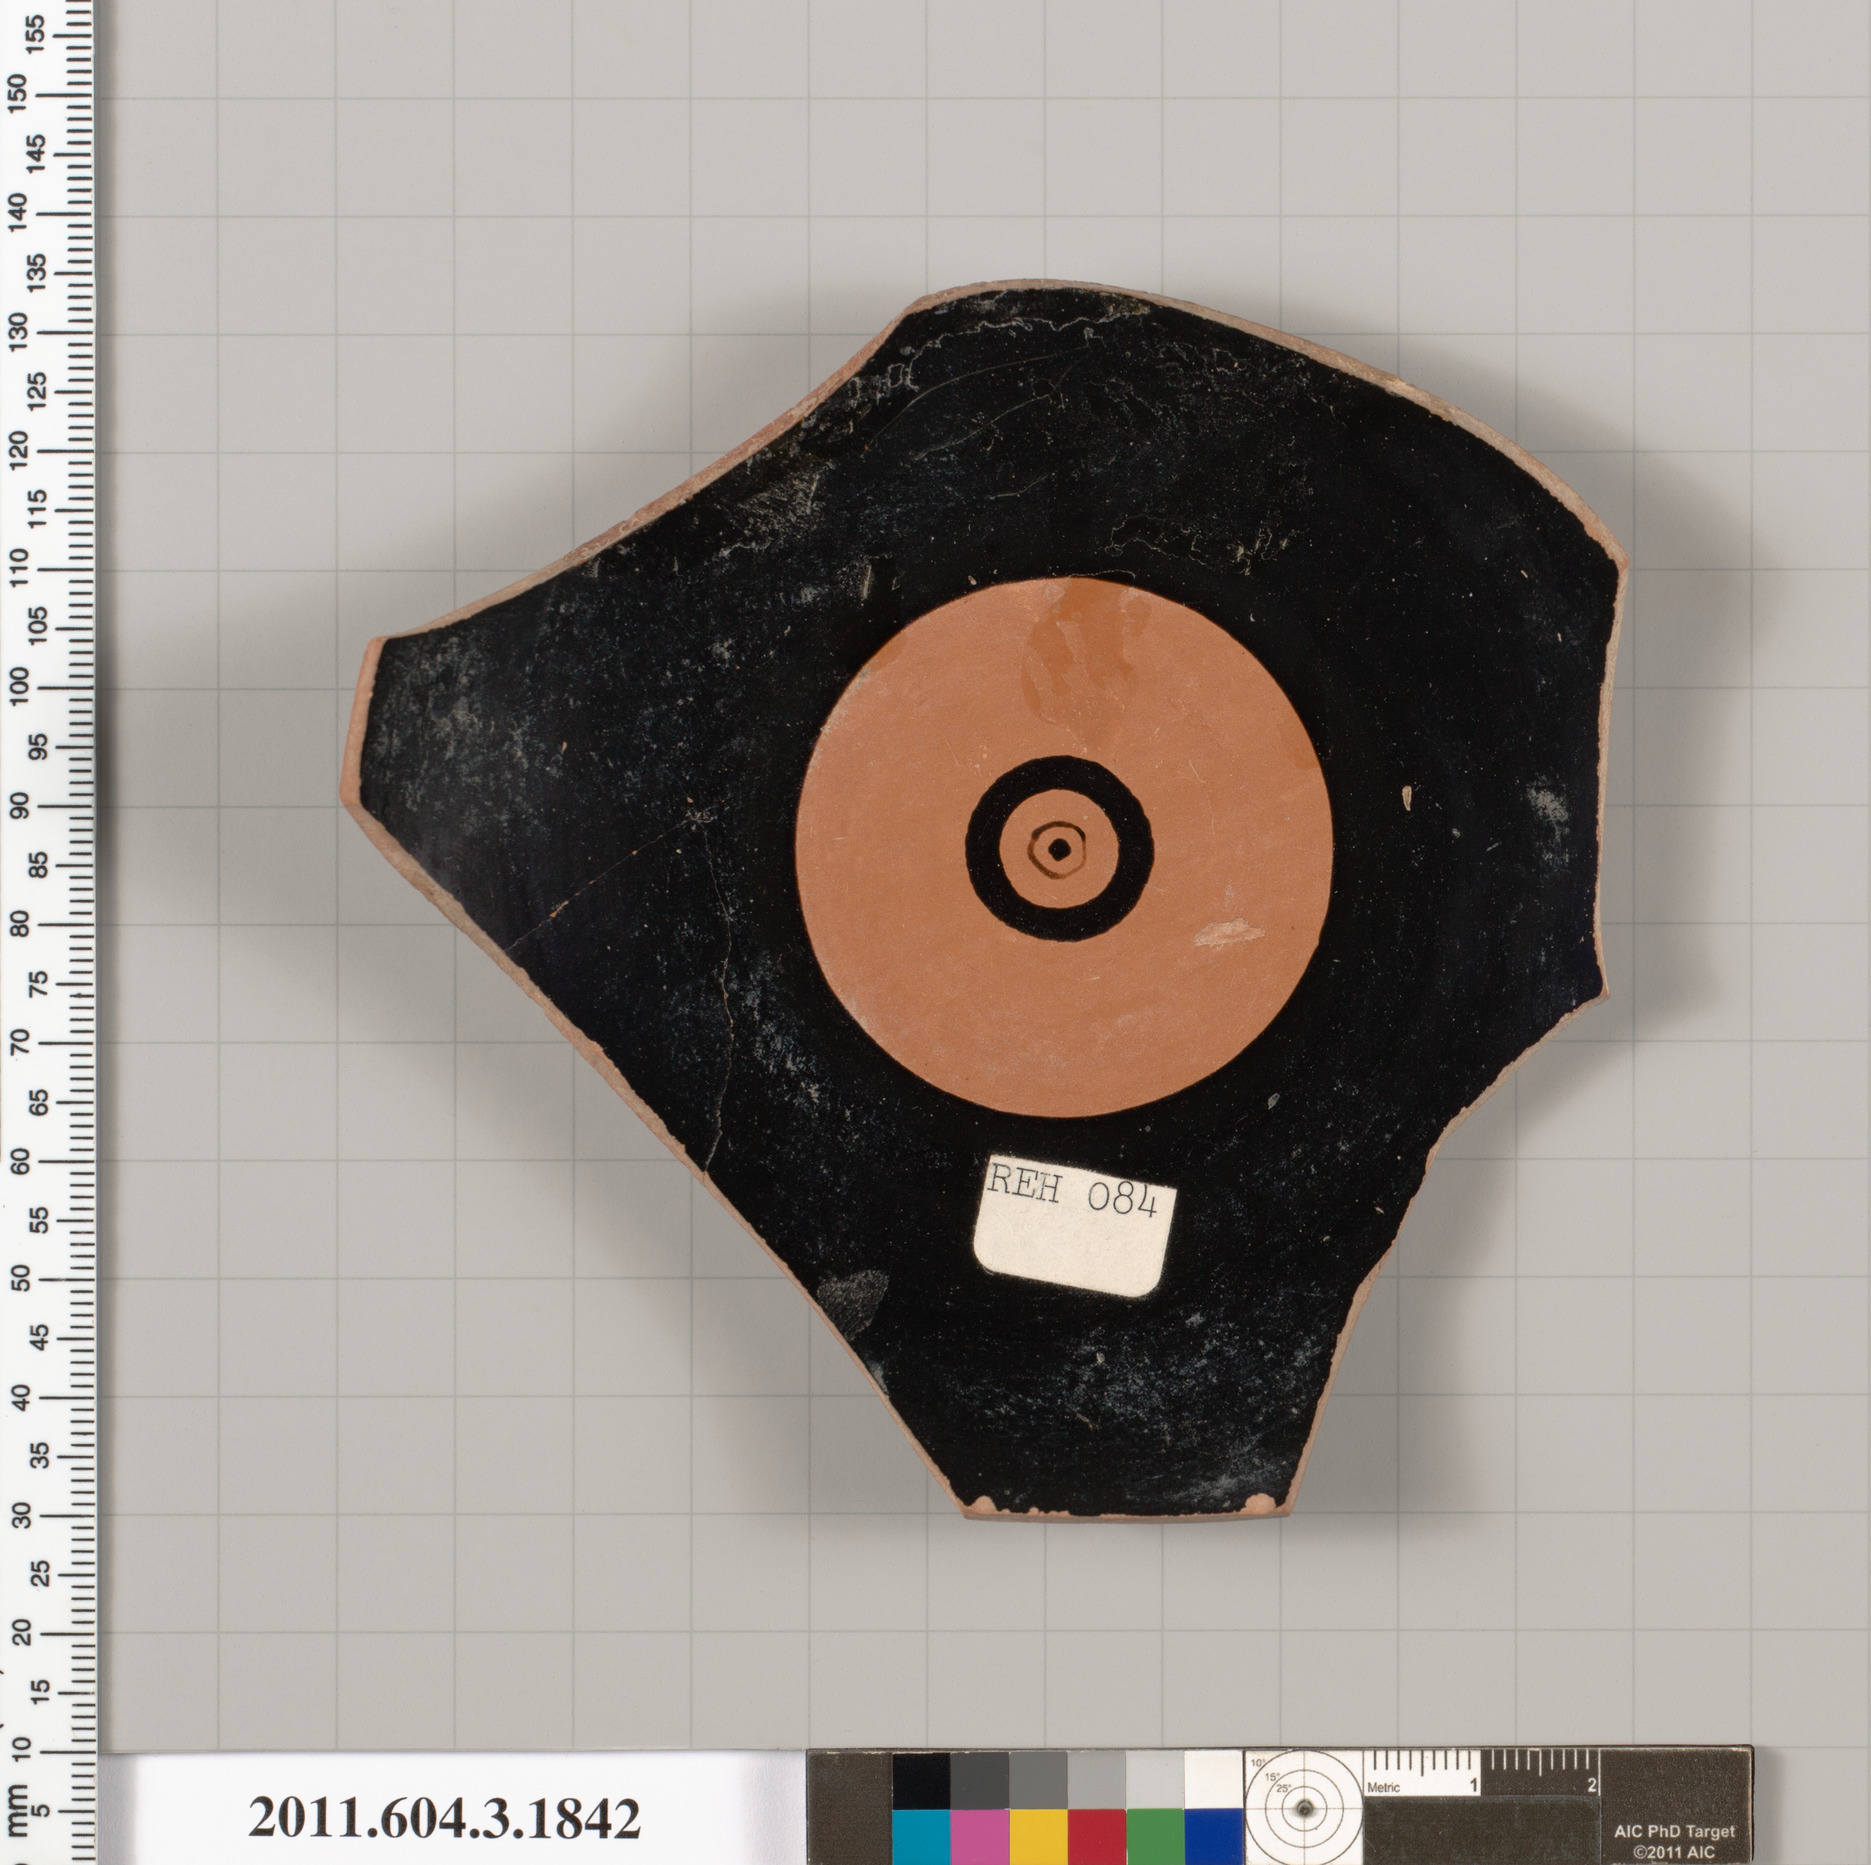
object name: kylix fragment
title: Terracotta fragment of a kylix: Lip cup (drinking cup)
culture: greek, attic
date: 567-535 BCE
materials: terracotta